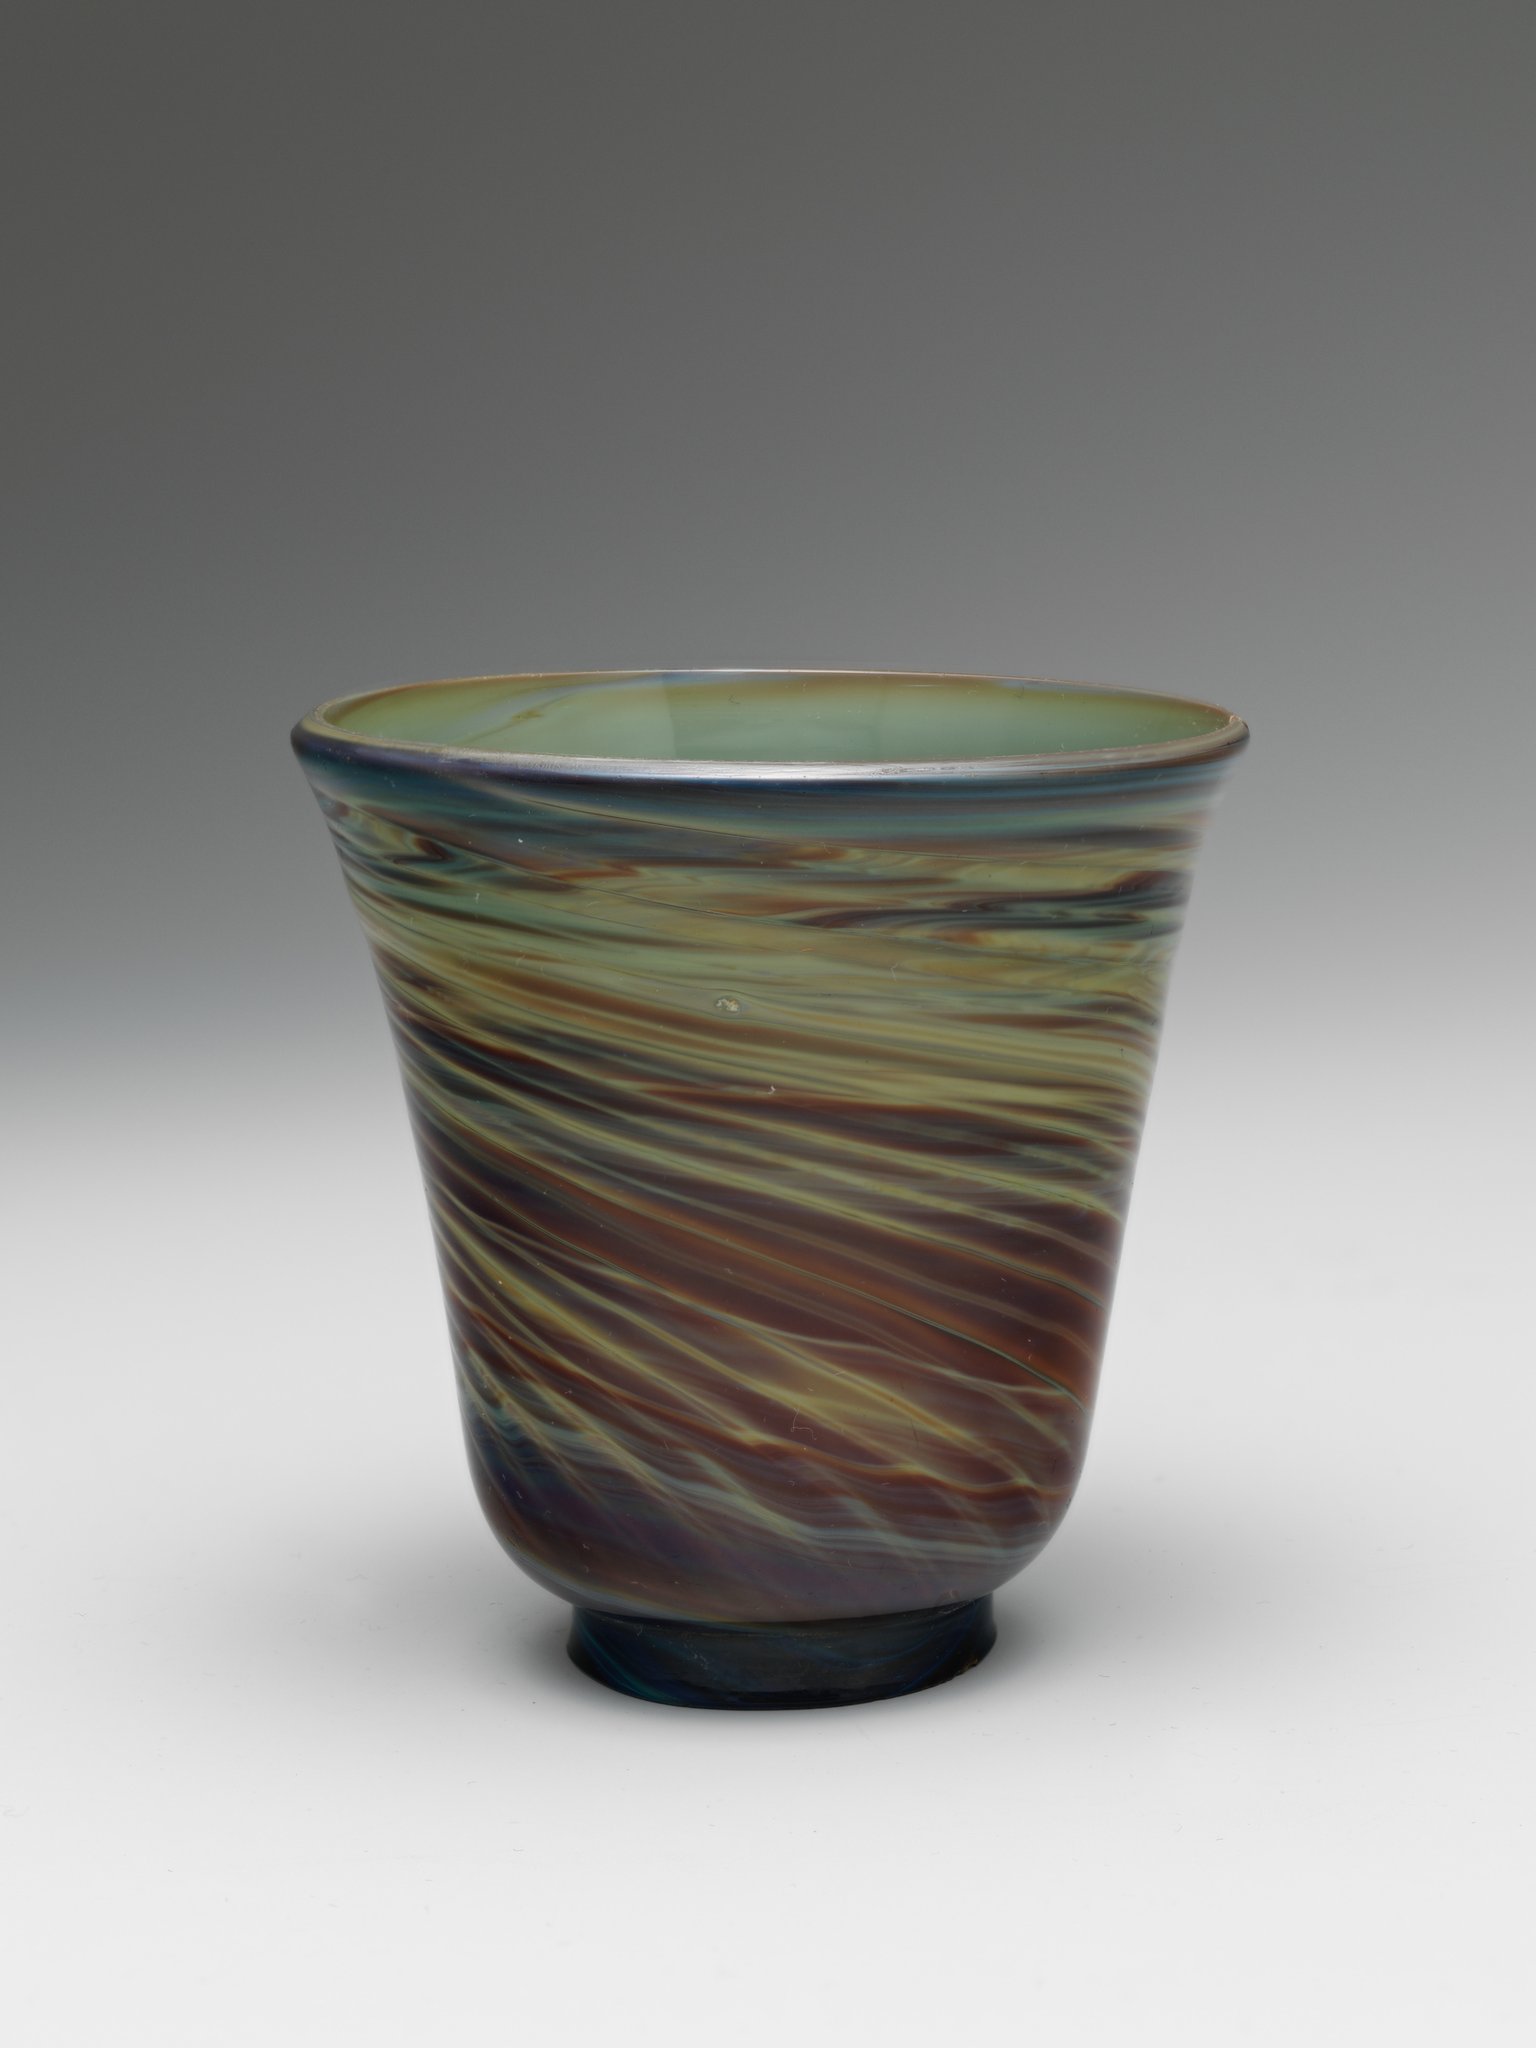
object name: cup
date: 1701-1900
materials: glass